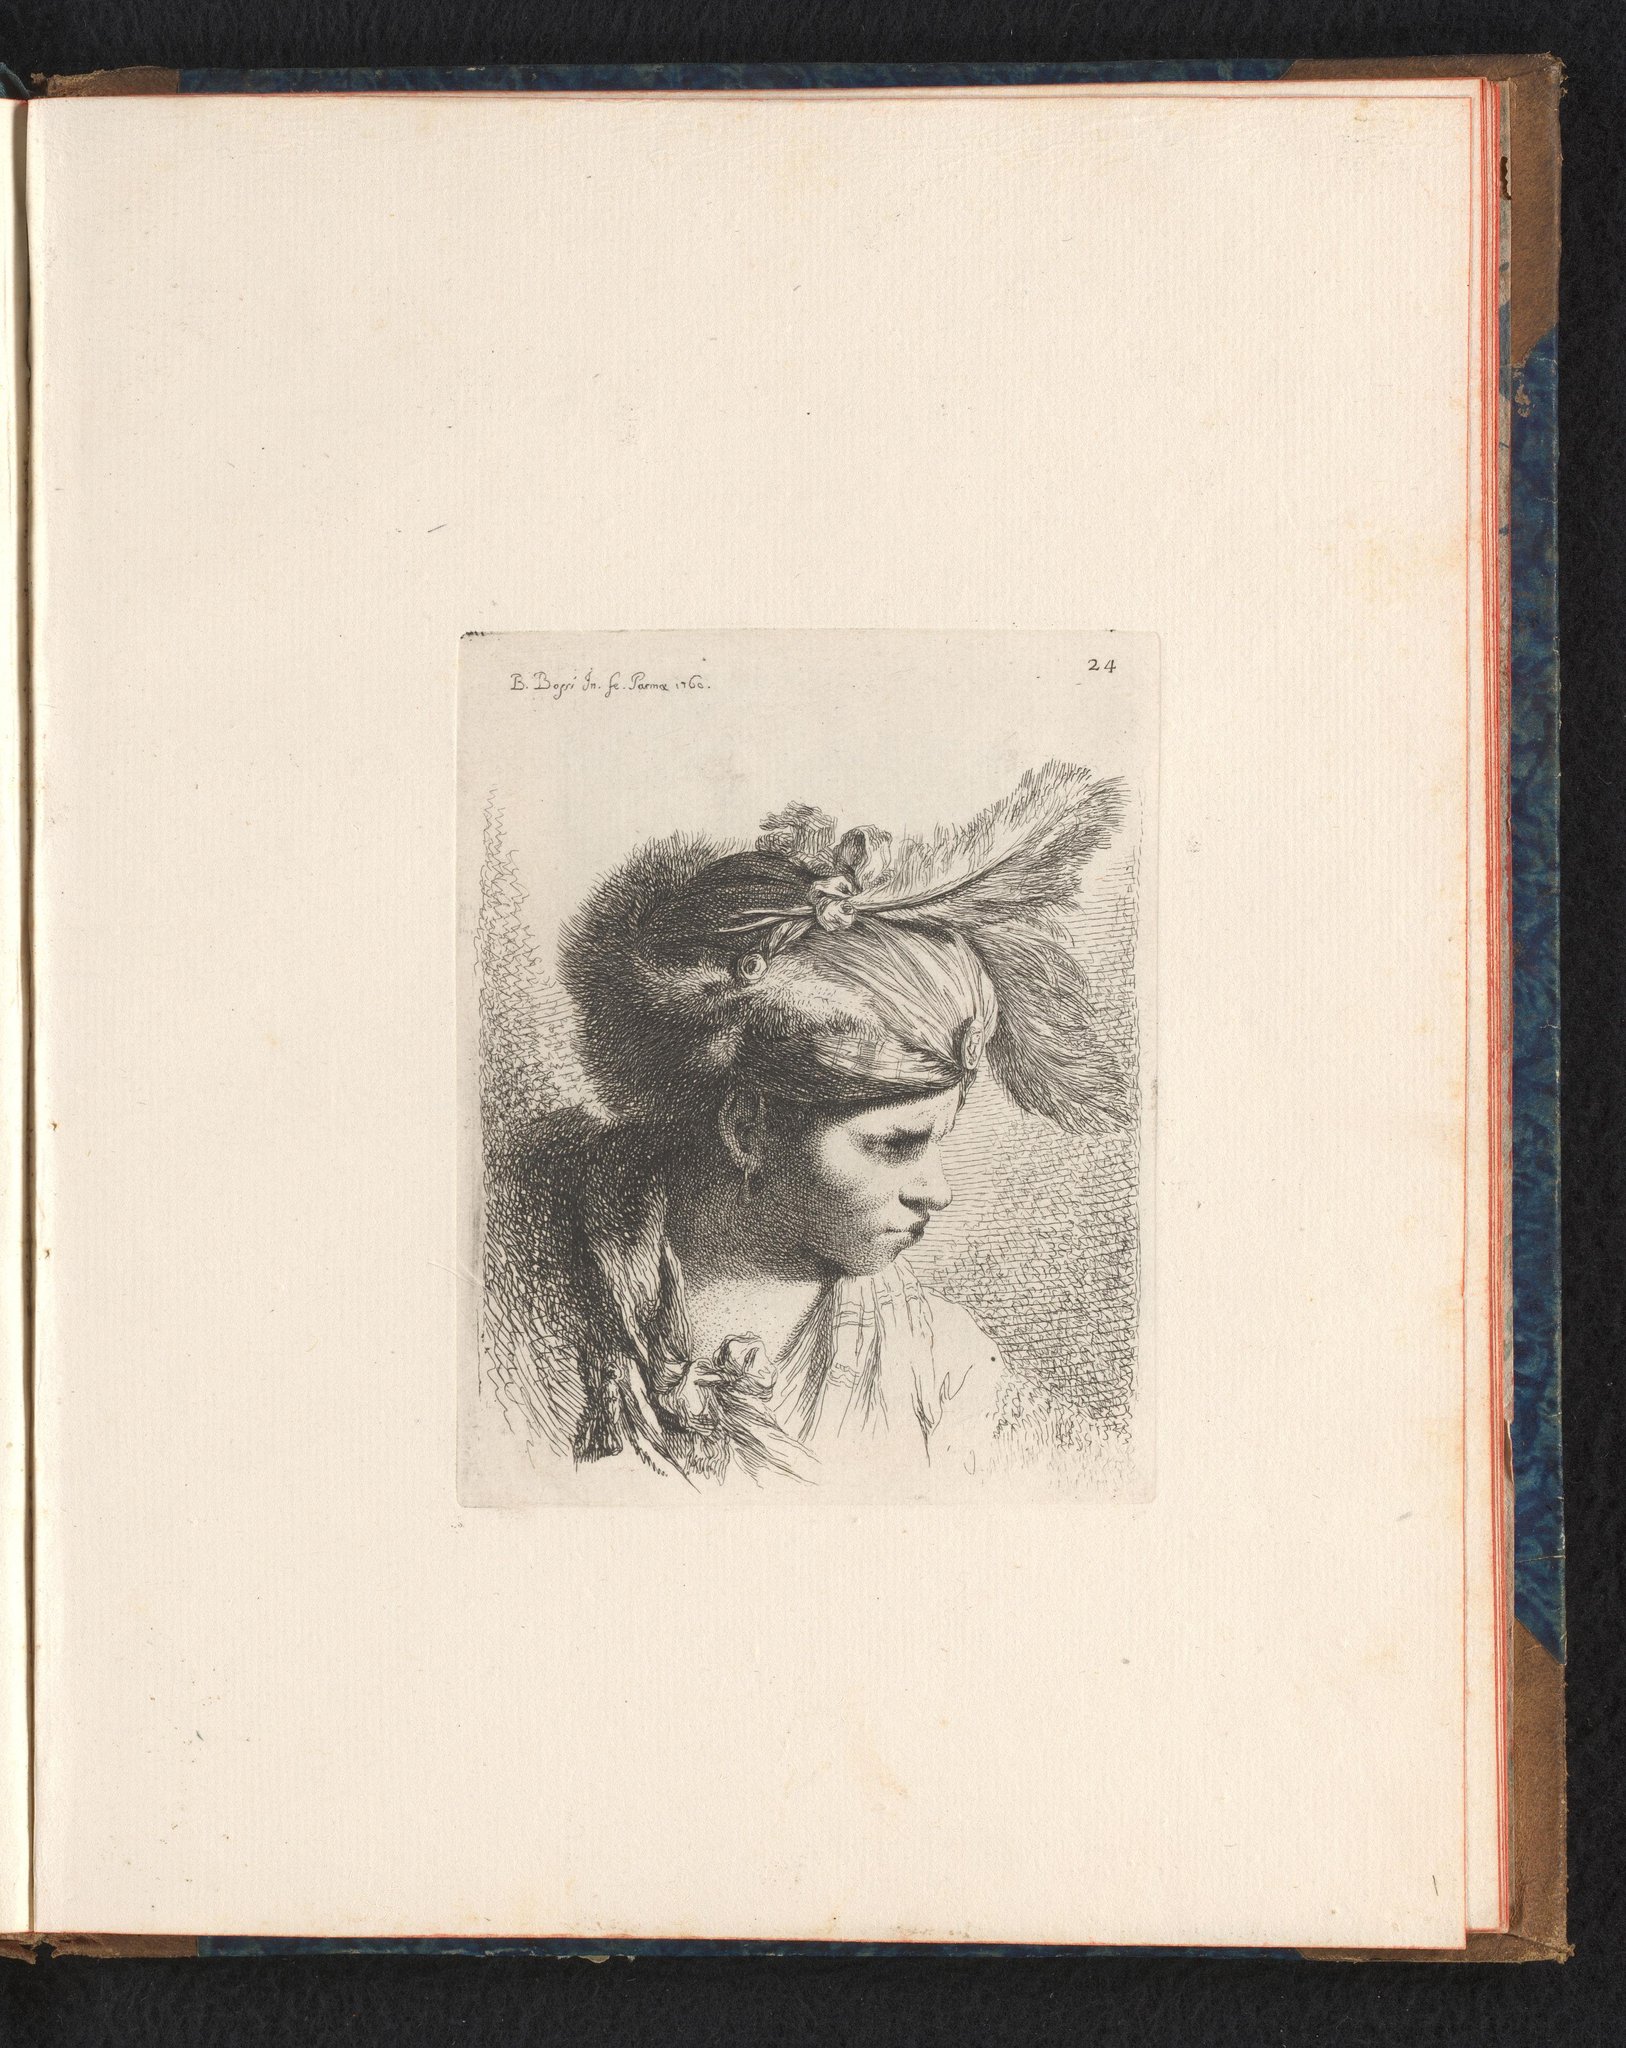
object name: print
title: Raccolta di teste, pensieri, trofei e prove varie d'acquaforte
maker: benigno bossi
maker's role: print maker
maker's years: 1727-1792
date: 1760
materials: paper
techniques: etching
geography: italy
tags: adult man, head-gear: turban